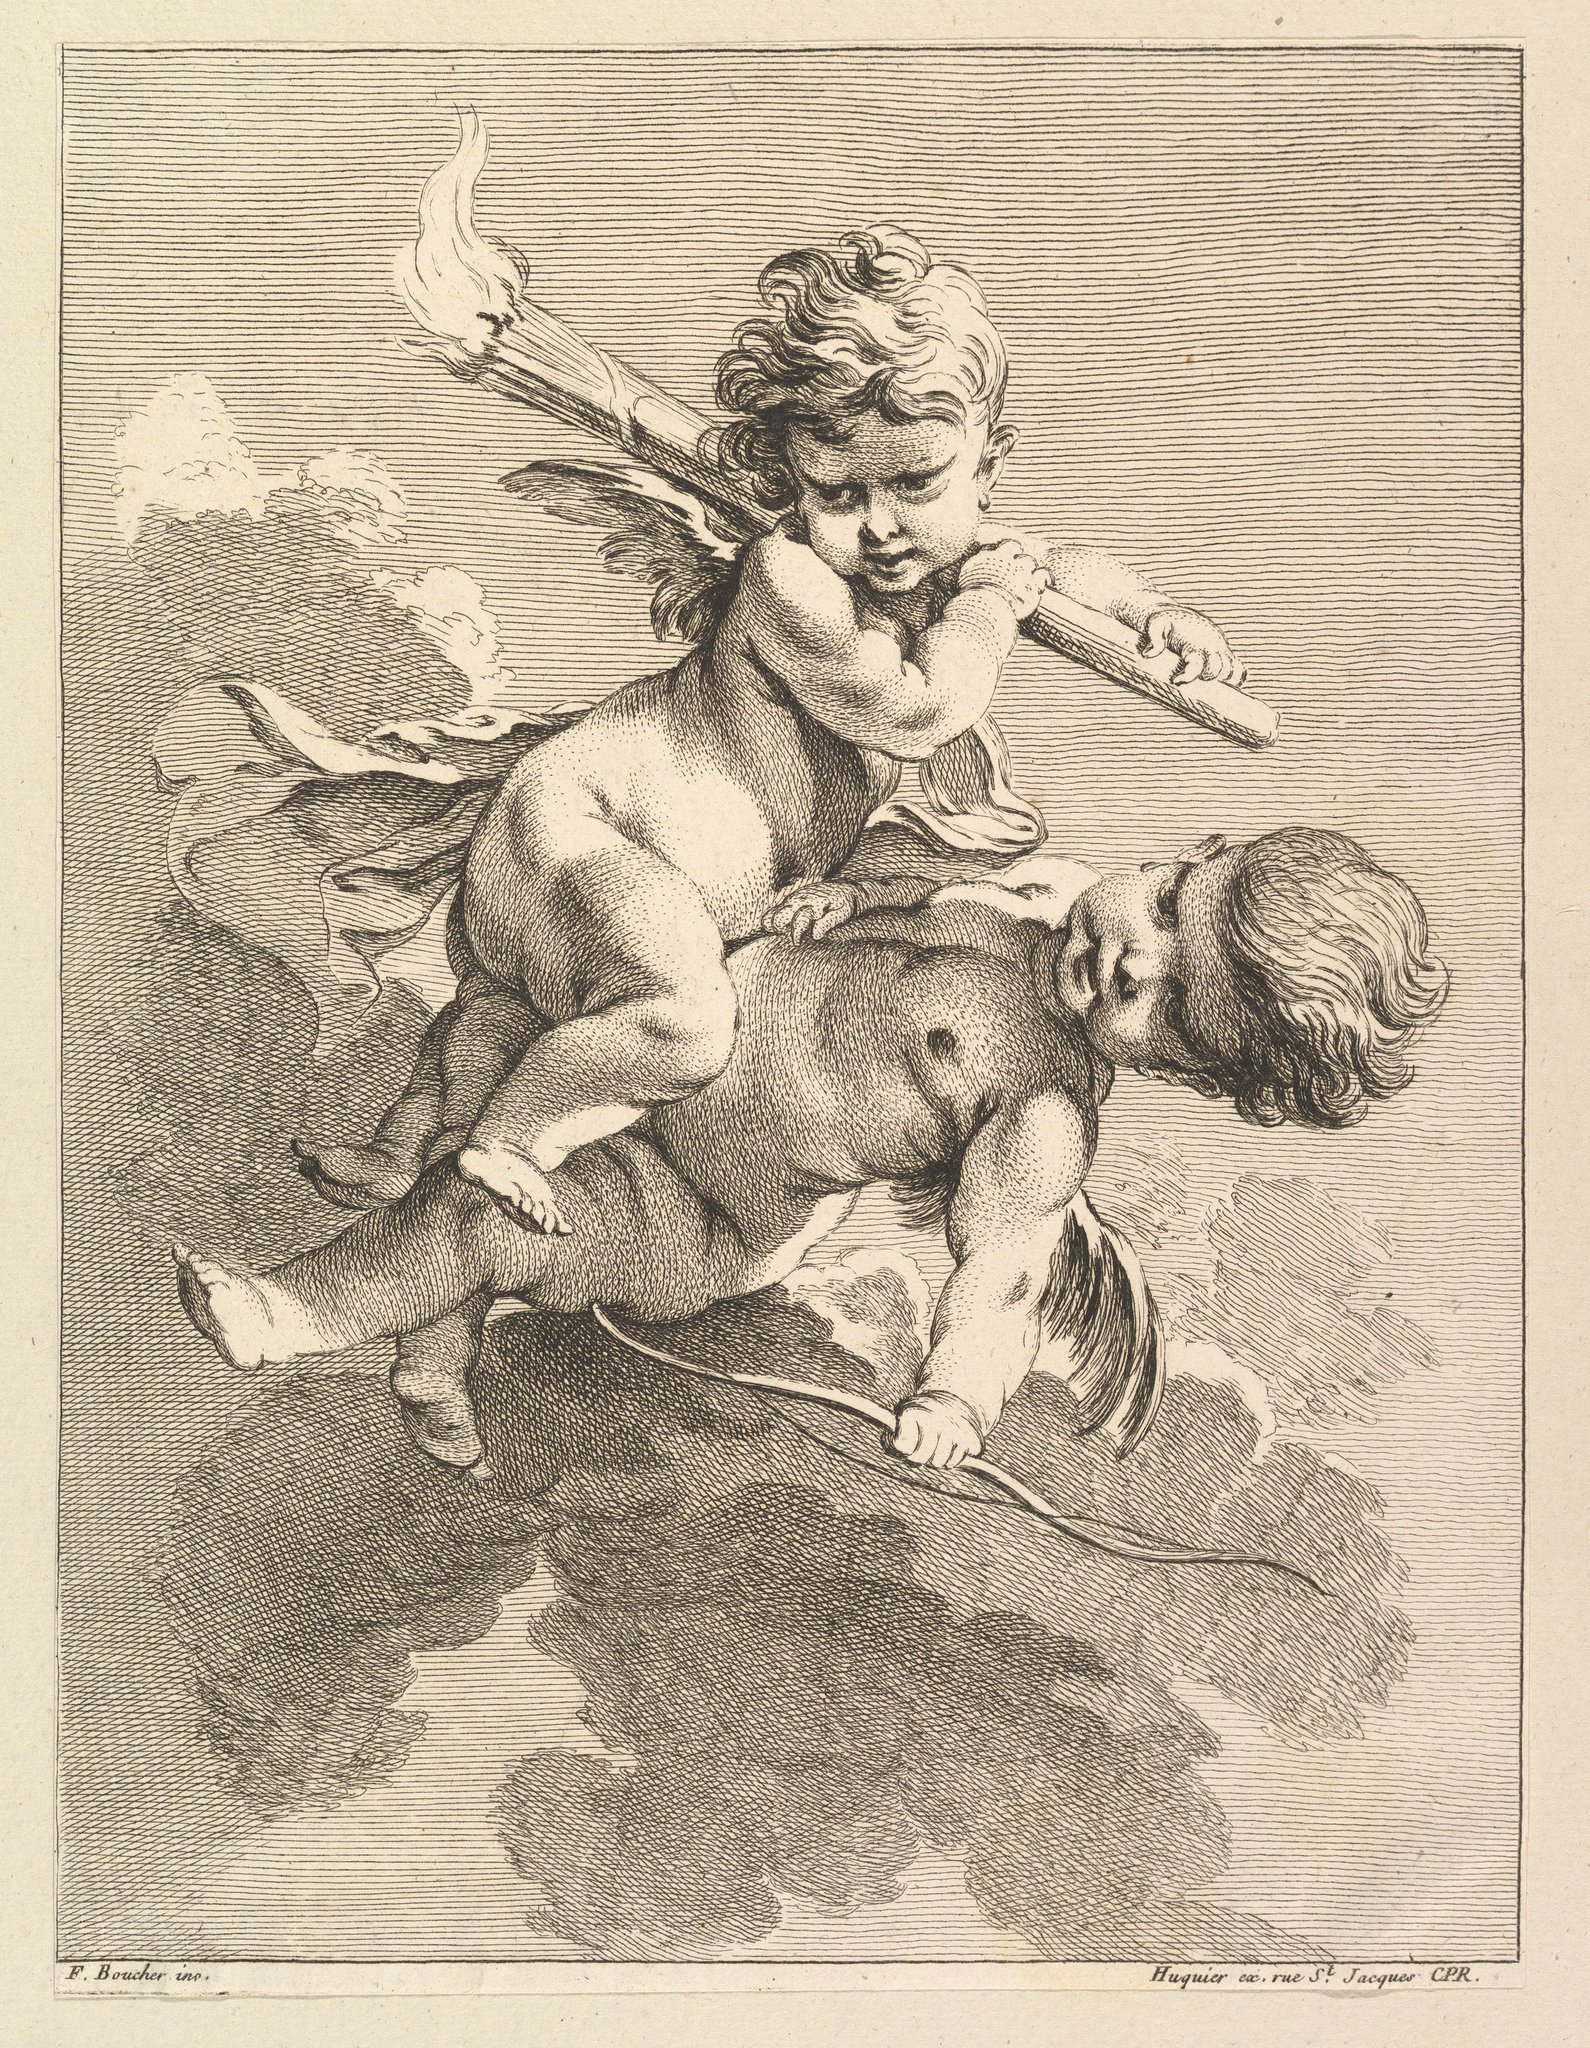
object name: print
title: Two Cupids, One Carrying a Torch, Another a Bow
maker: pierre alexandre aveline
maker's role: artist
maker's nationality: french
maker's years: 1702-1760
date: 1727-1760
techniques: engraving, etching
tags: military equipment,cupid